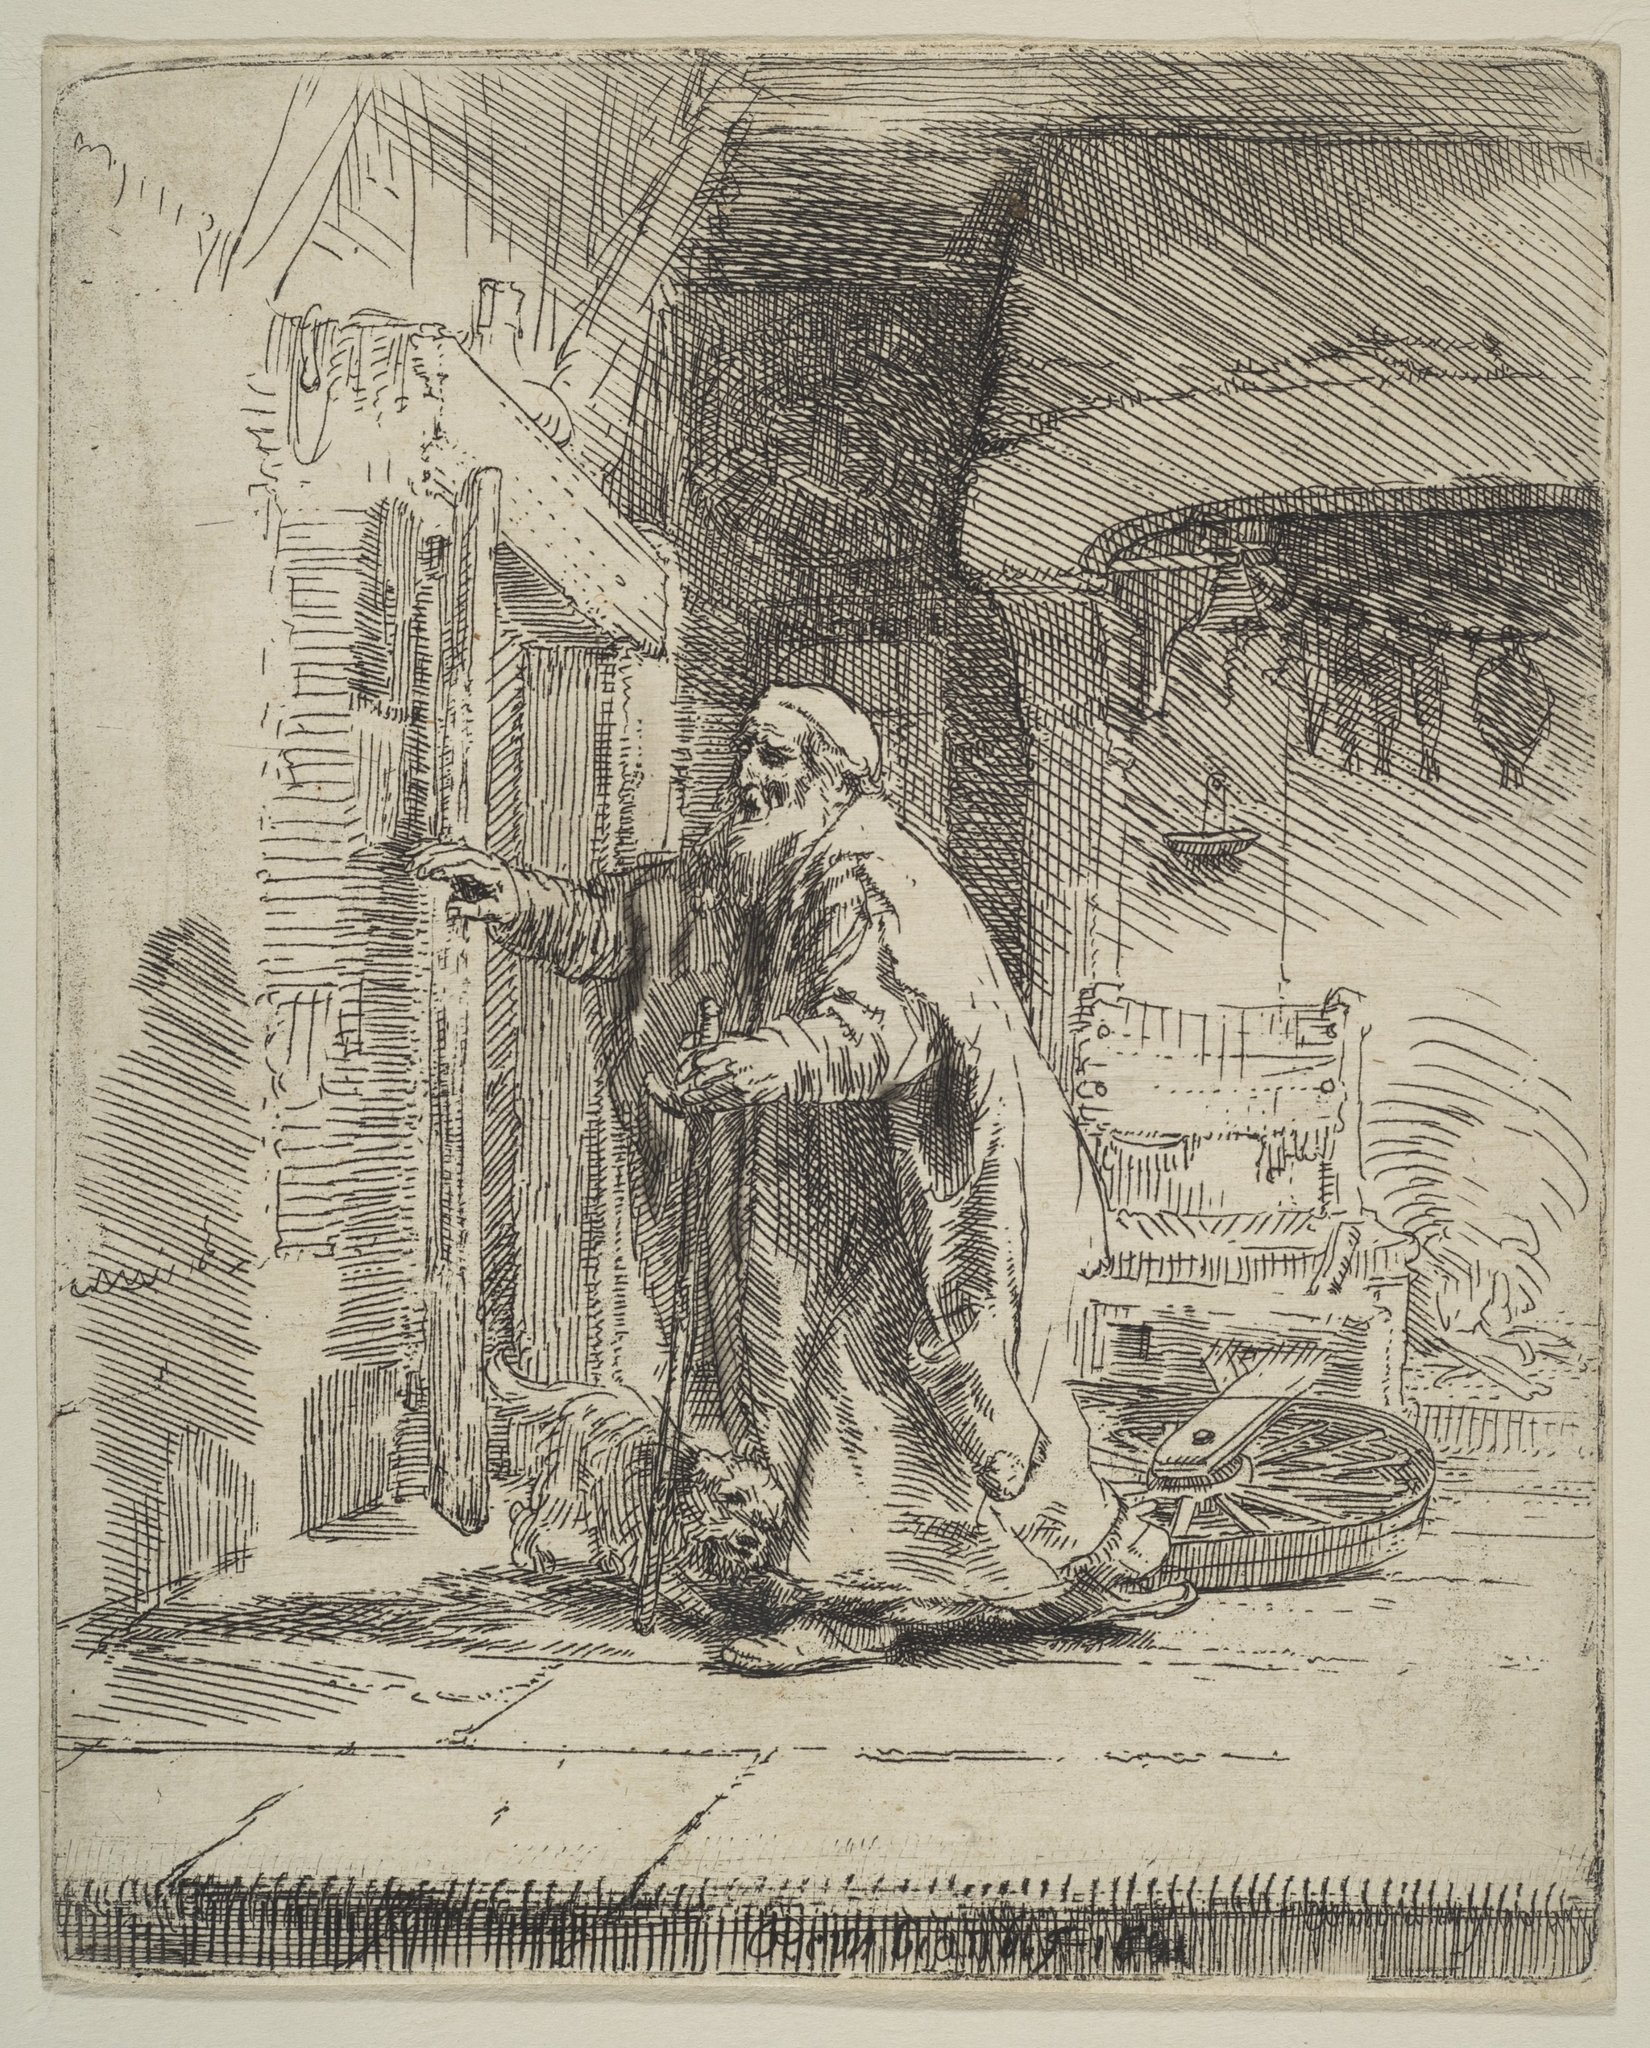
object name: print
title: The Blindness of Tobit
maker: rembrandt van rijn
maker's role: artist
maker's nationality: dutch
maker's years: 1606-1669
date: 1651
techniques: drypoint, etching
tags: fireplaces,interiors,men,dogs,fish,chairs